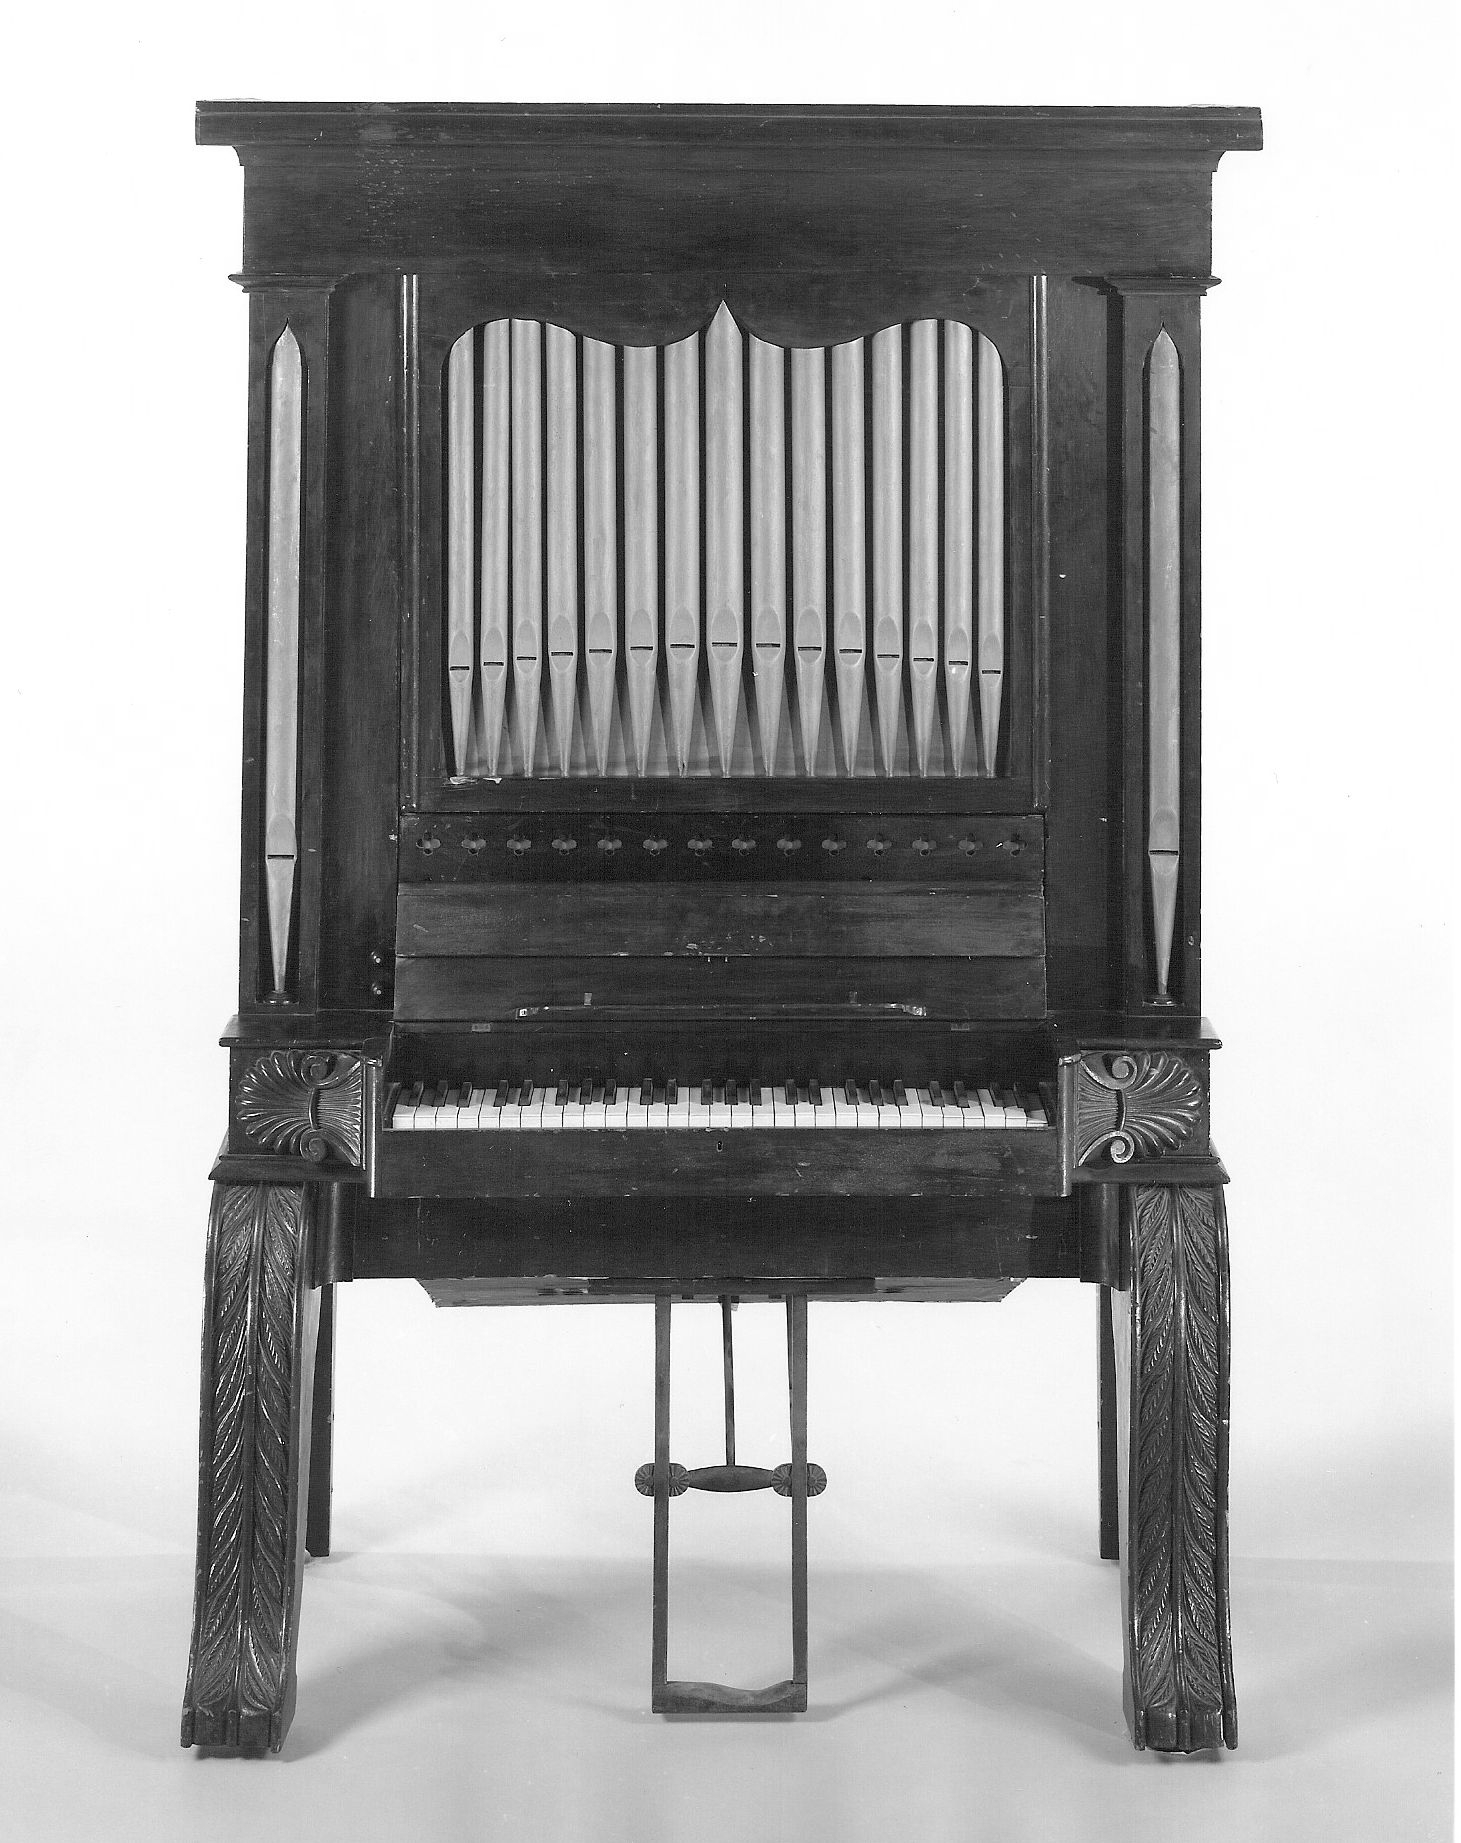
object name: chamber organ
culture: american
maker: george clisbee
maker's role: maker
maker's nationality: american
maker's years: 1828-1885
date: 1845-1860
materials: wood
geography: united states